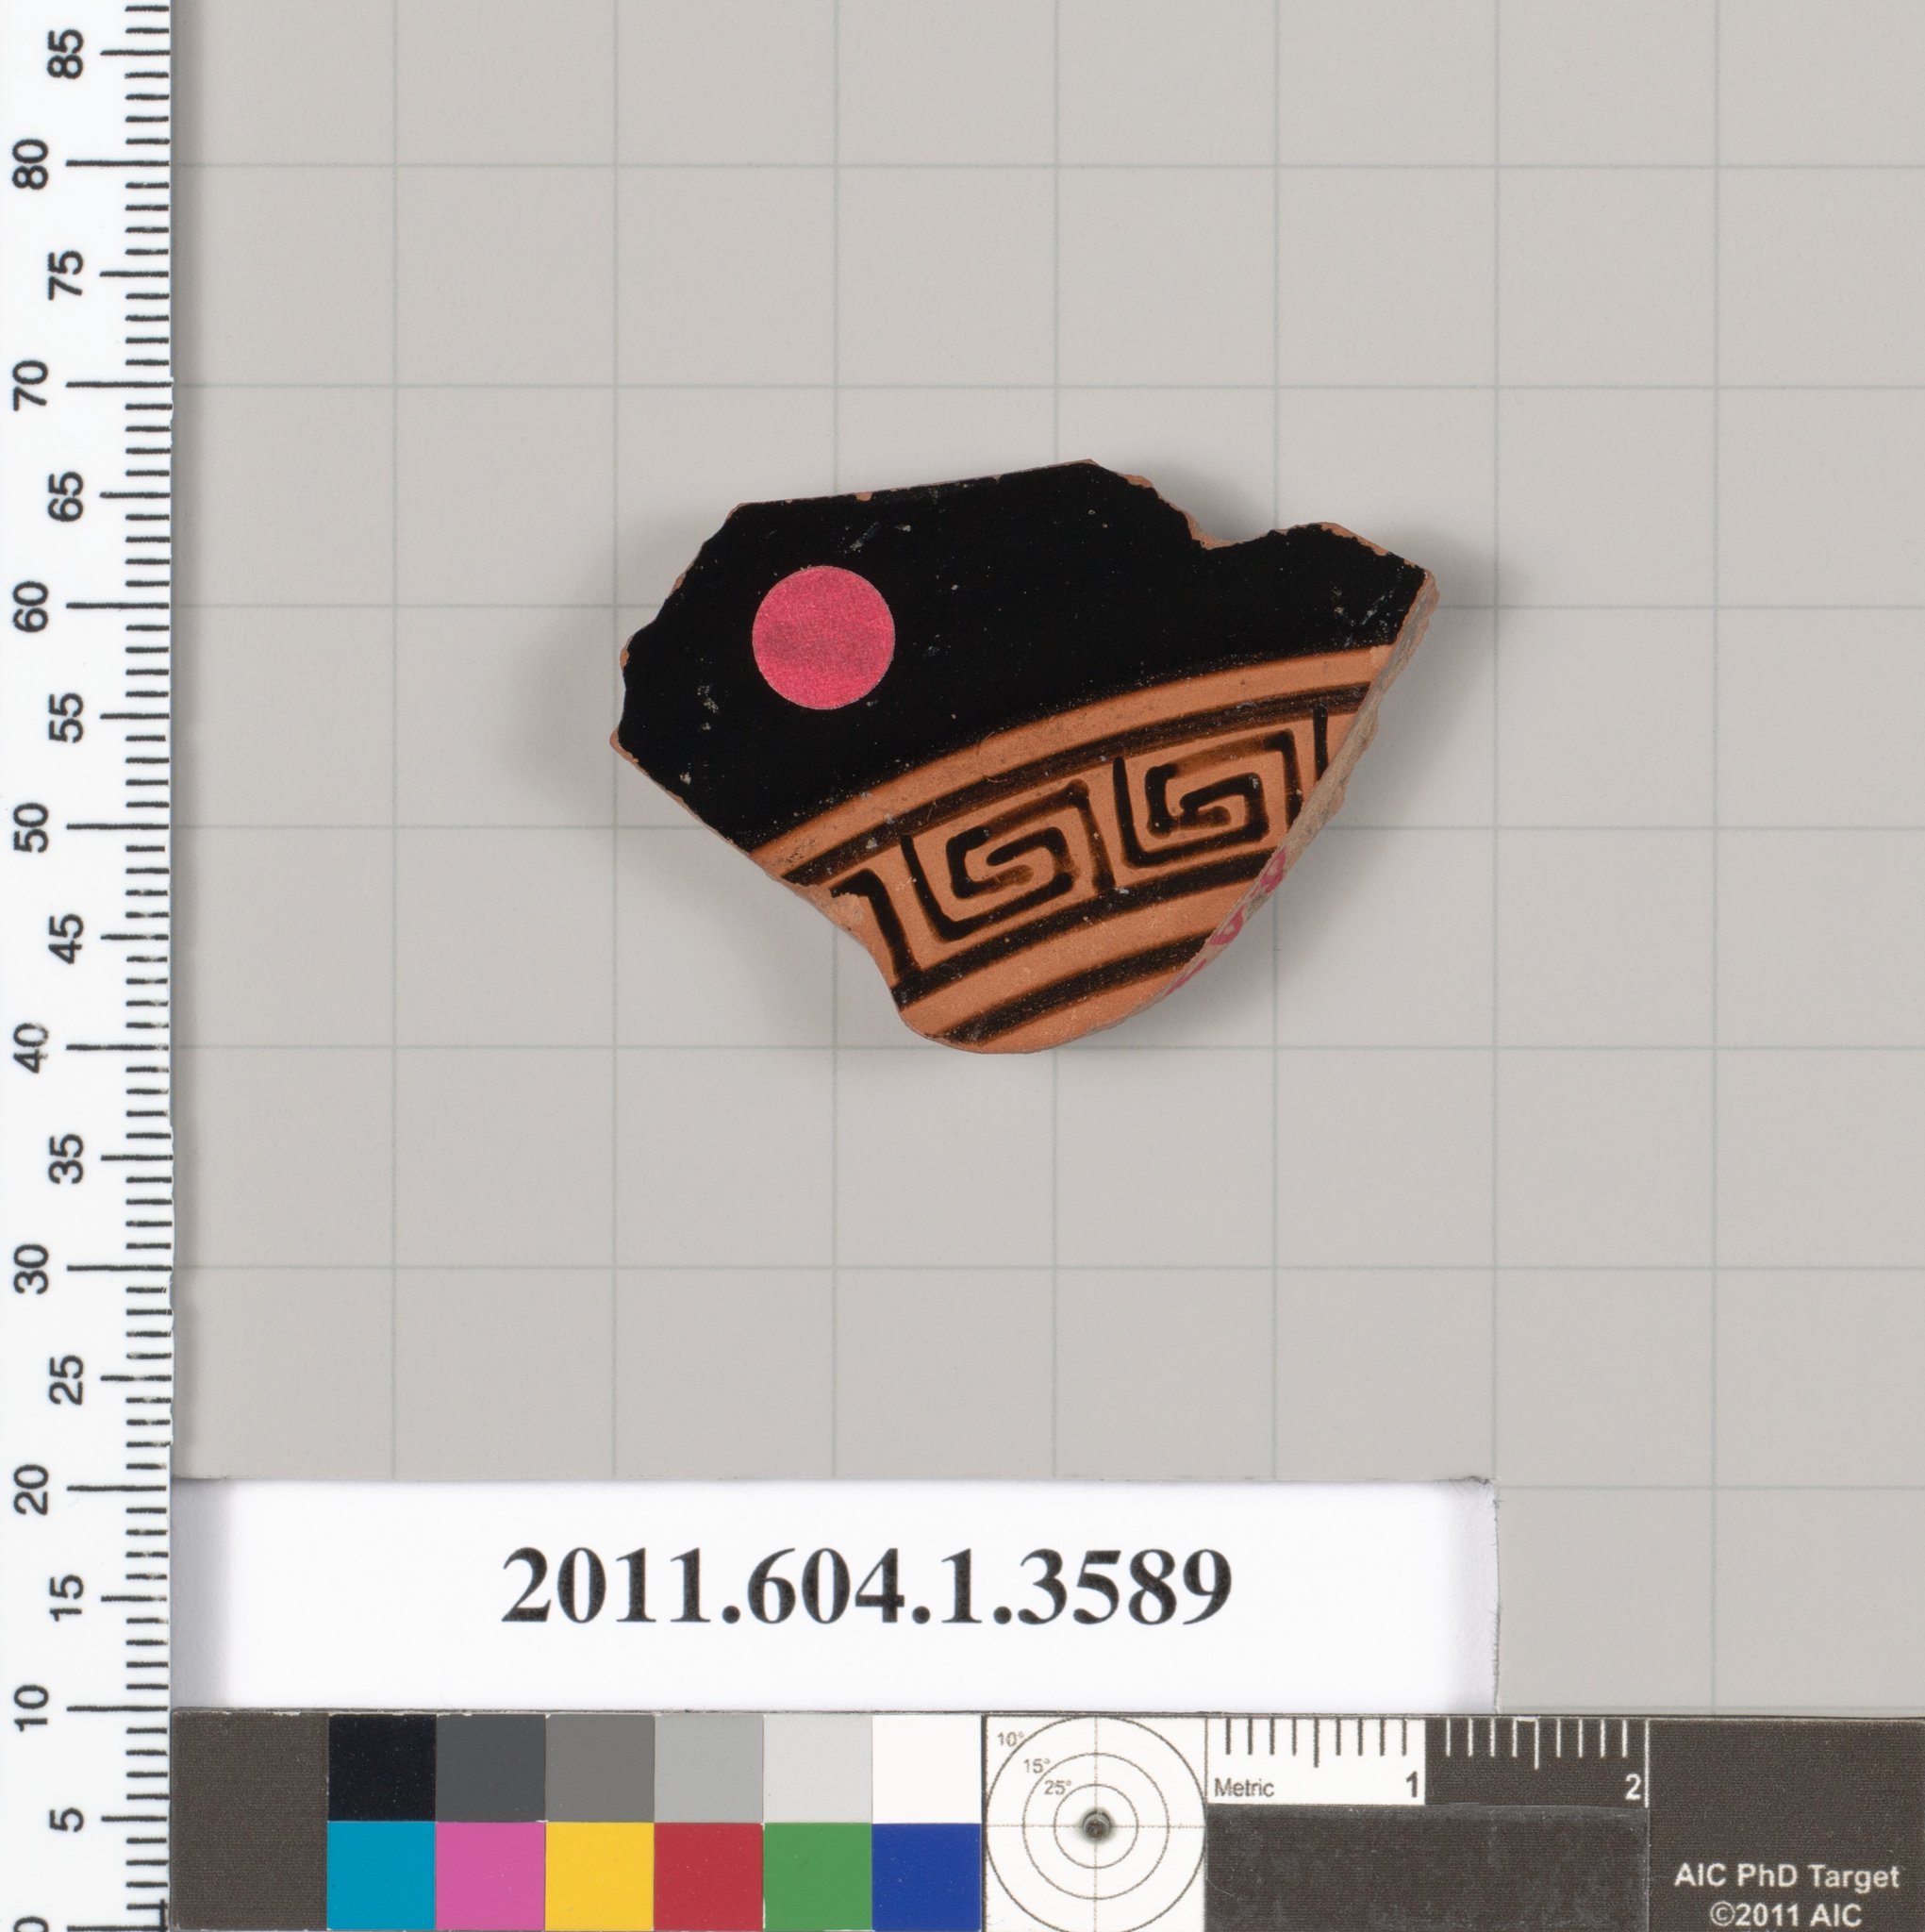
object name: kylix fragment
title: Terracotta fragment of a kylix (drinking cup)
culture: greek, attic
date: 500-476 BCE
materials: terracotta